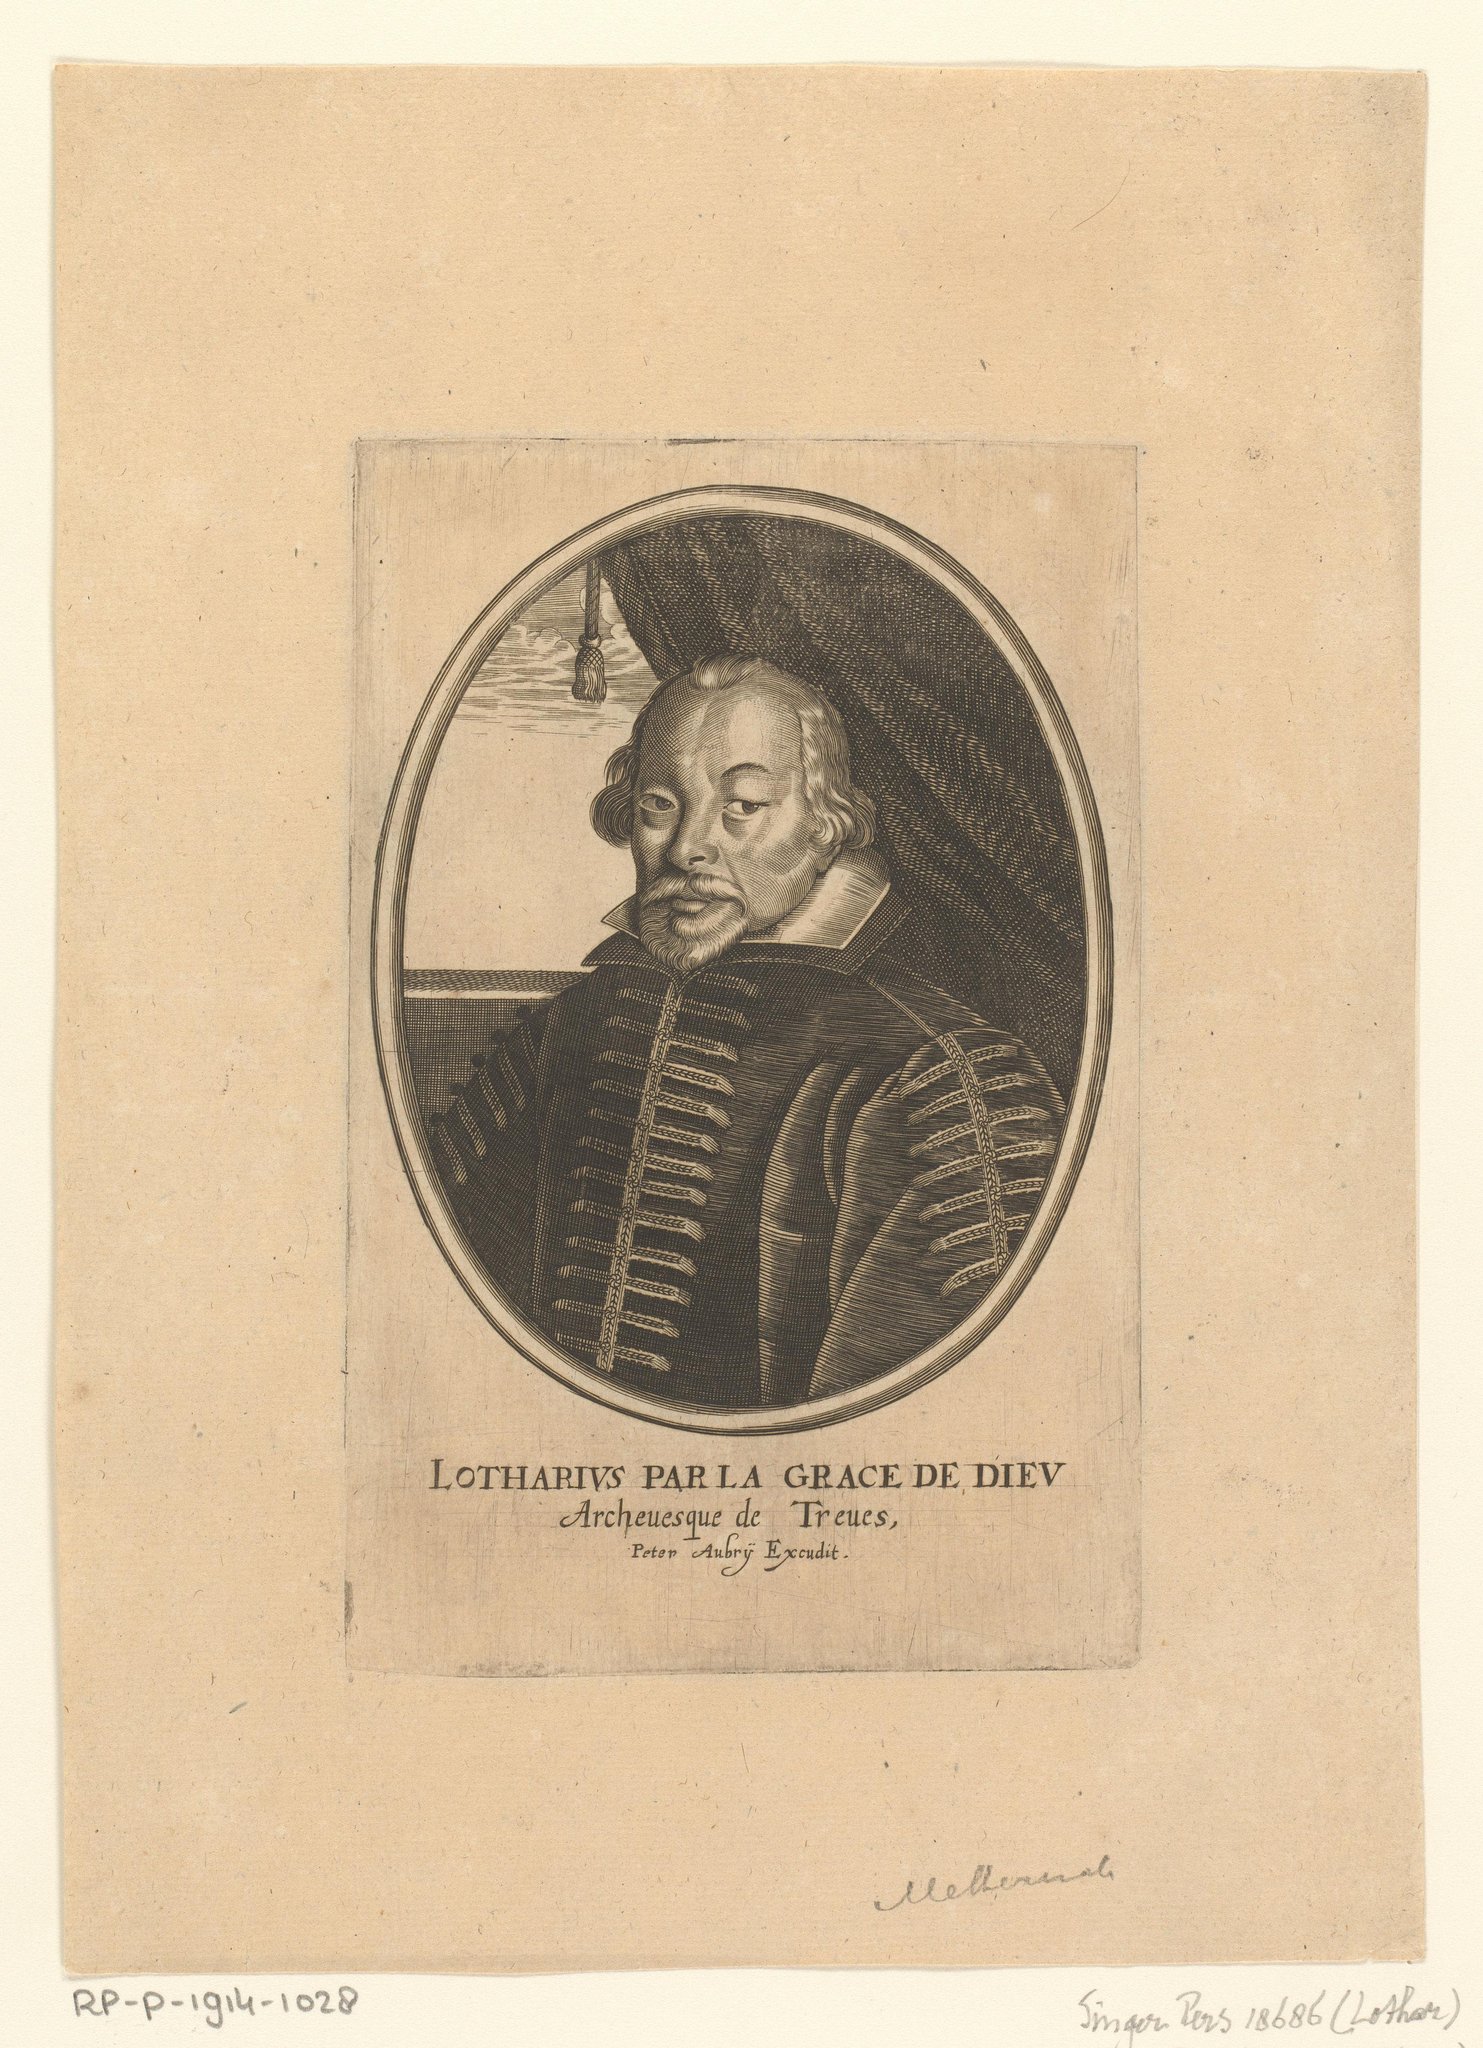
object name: print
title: Portret van Lothar van Metternich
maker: Anonymous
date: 1606-1686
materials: paper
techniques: engraving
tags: archbishop, bishop, etc. (roman catholic), historical persons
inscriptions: collector's mark: Lugt 2228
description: Met tweeregelig onderschrift in het Frans.